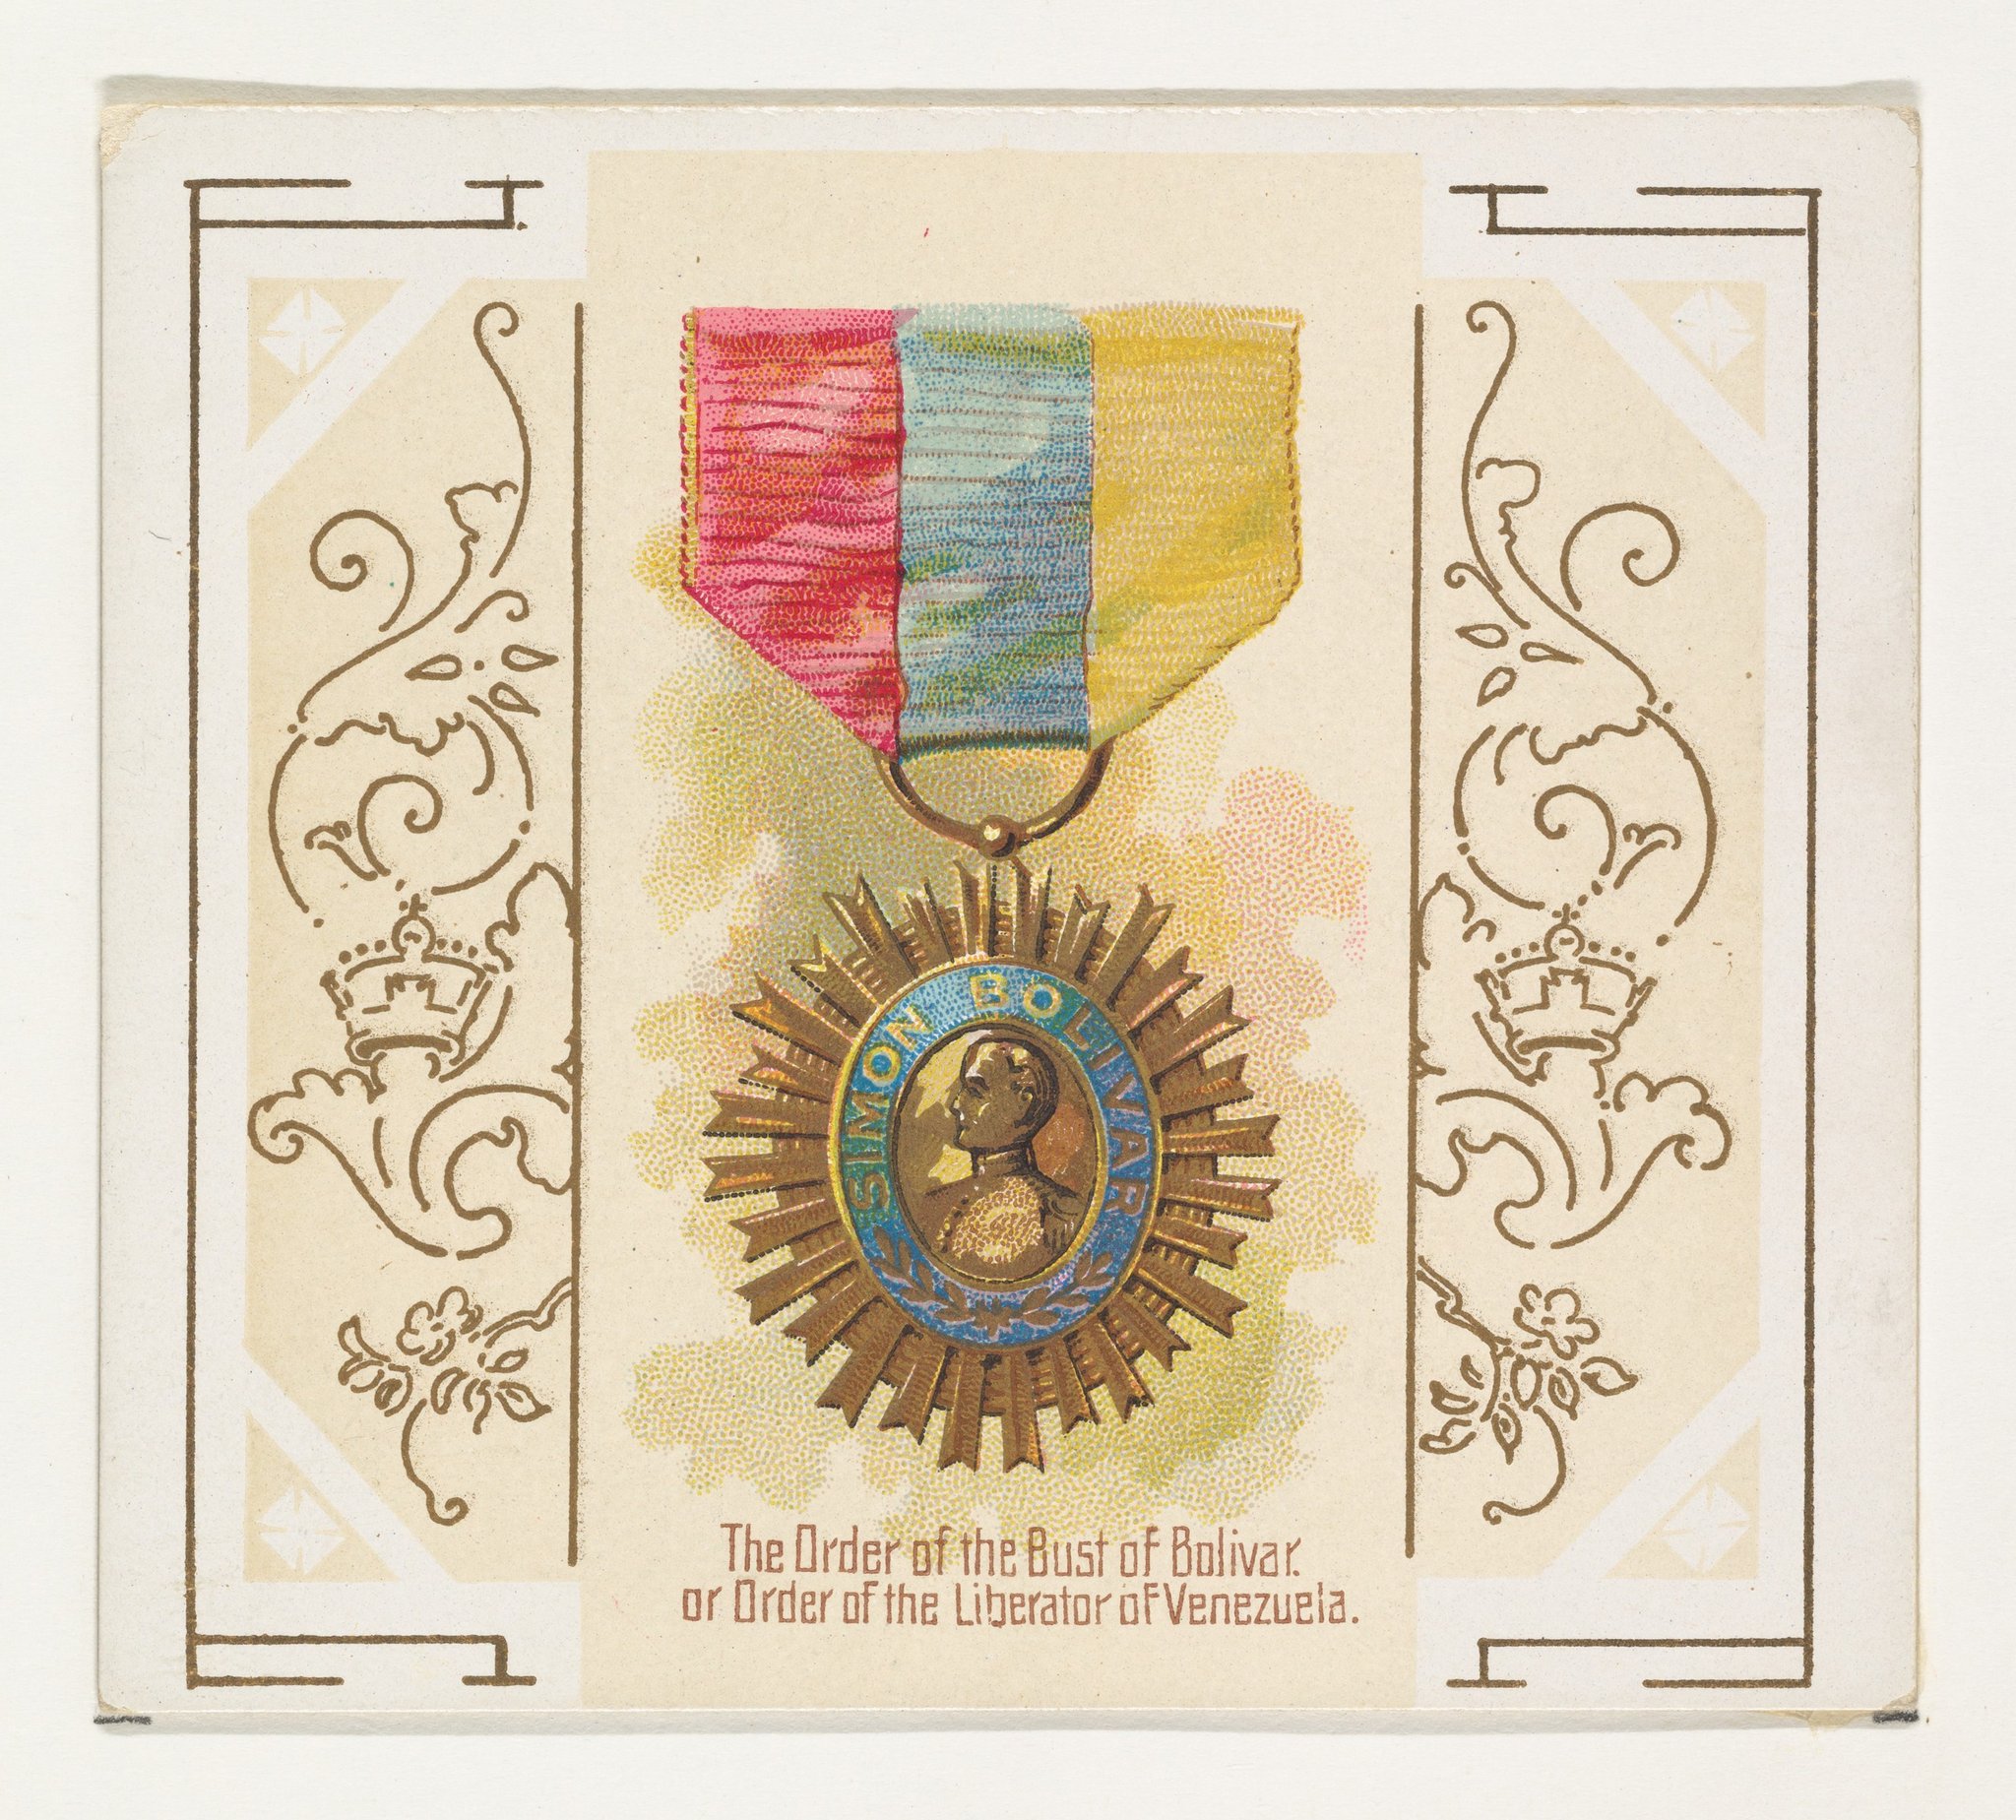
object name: print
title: The Order of the Bust of Bolivar, or Order of the Liberator of Venezuela, from the World's Decorations series (N44) for Allen & Ginter Cigarettes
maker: allen & ginter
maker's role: publisher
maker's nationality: american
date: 1890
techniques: color lithograph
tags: medals